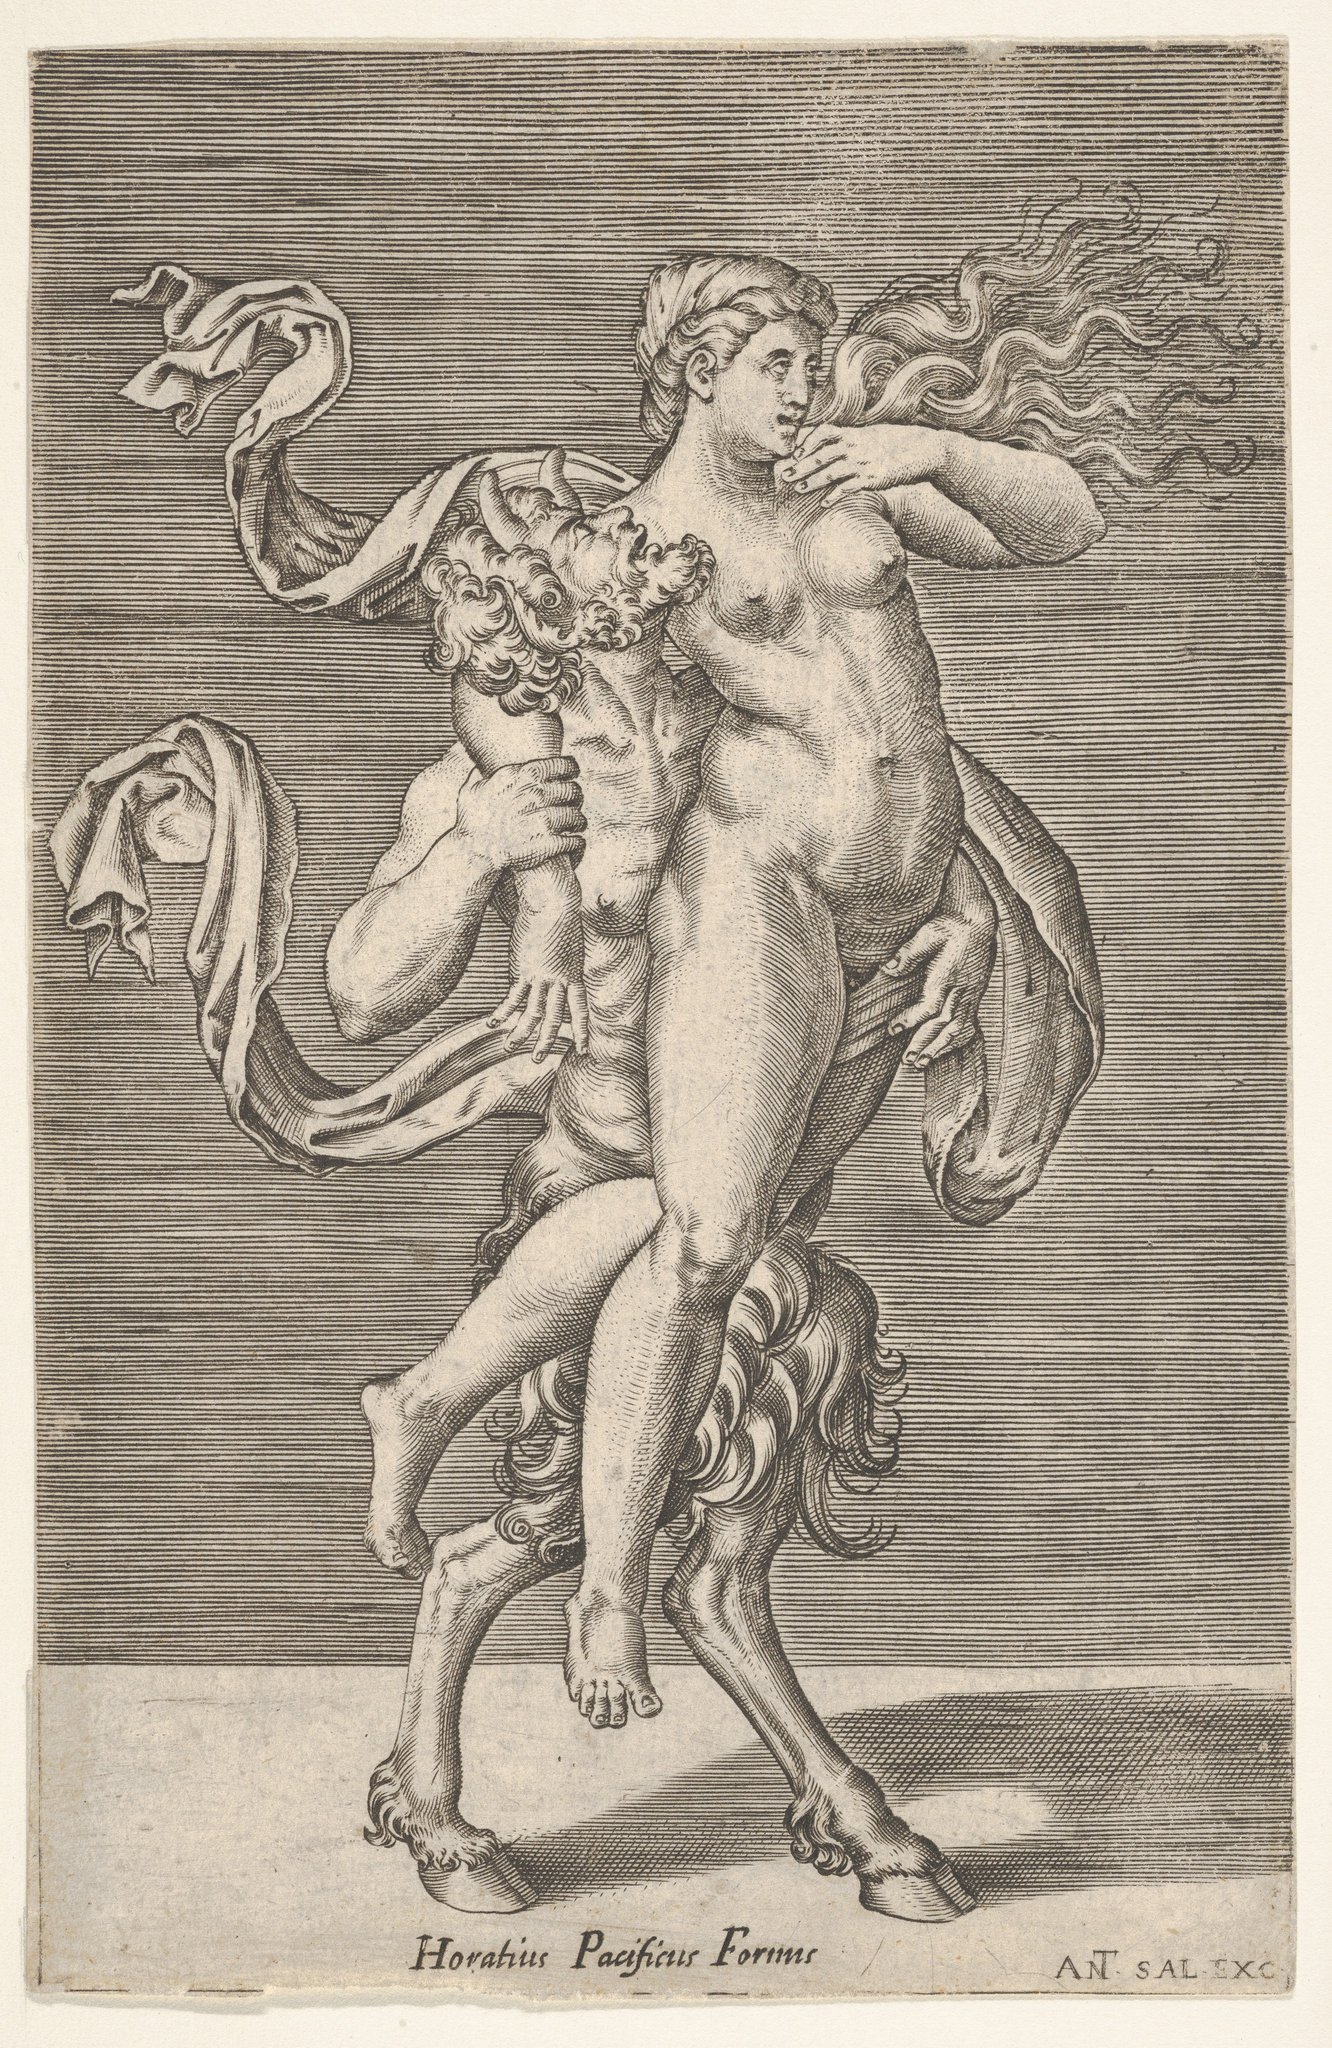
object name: print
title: Satyr carrying a nymph, whose right arm is wrapped around the satyr's neck, with a planar background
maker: giulio romano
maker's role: artist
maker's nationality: italian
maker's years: 1499-1546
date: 1505-1562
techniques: engraving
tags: nymphs,satyrs